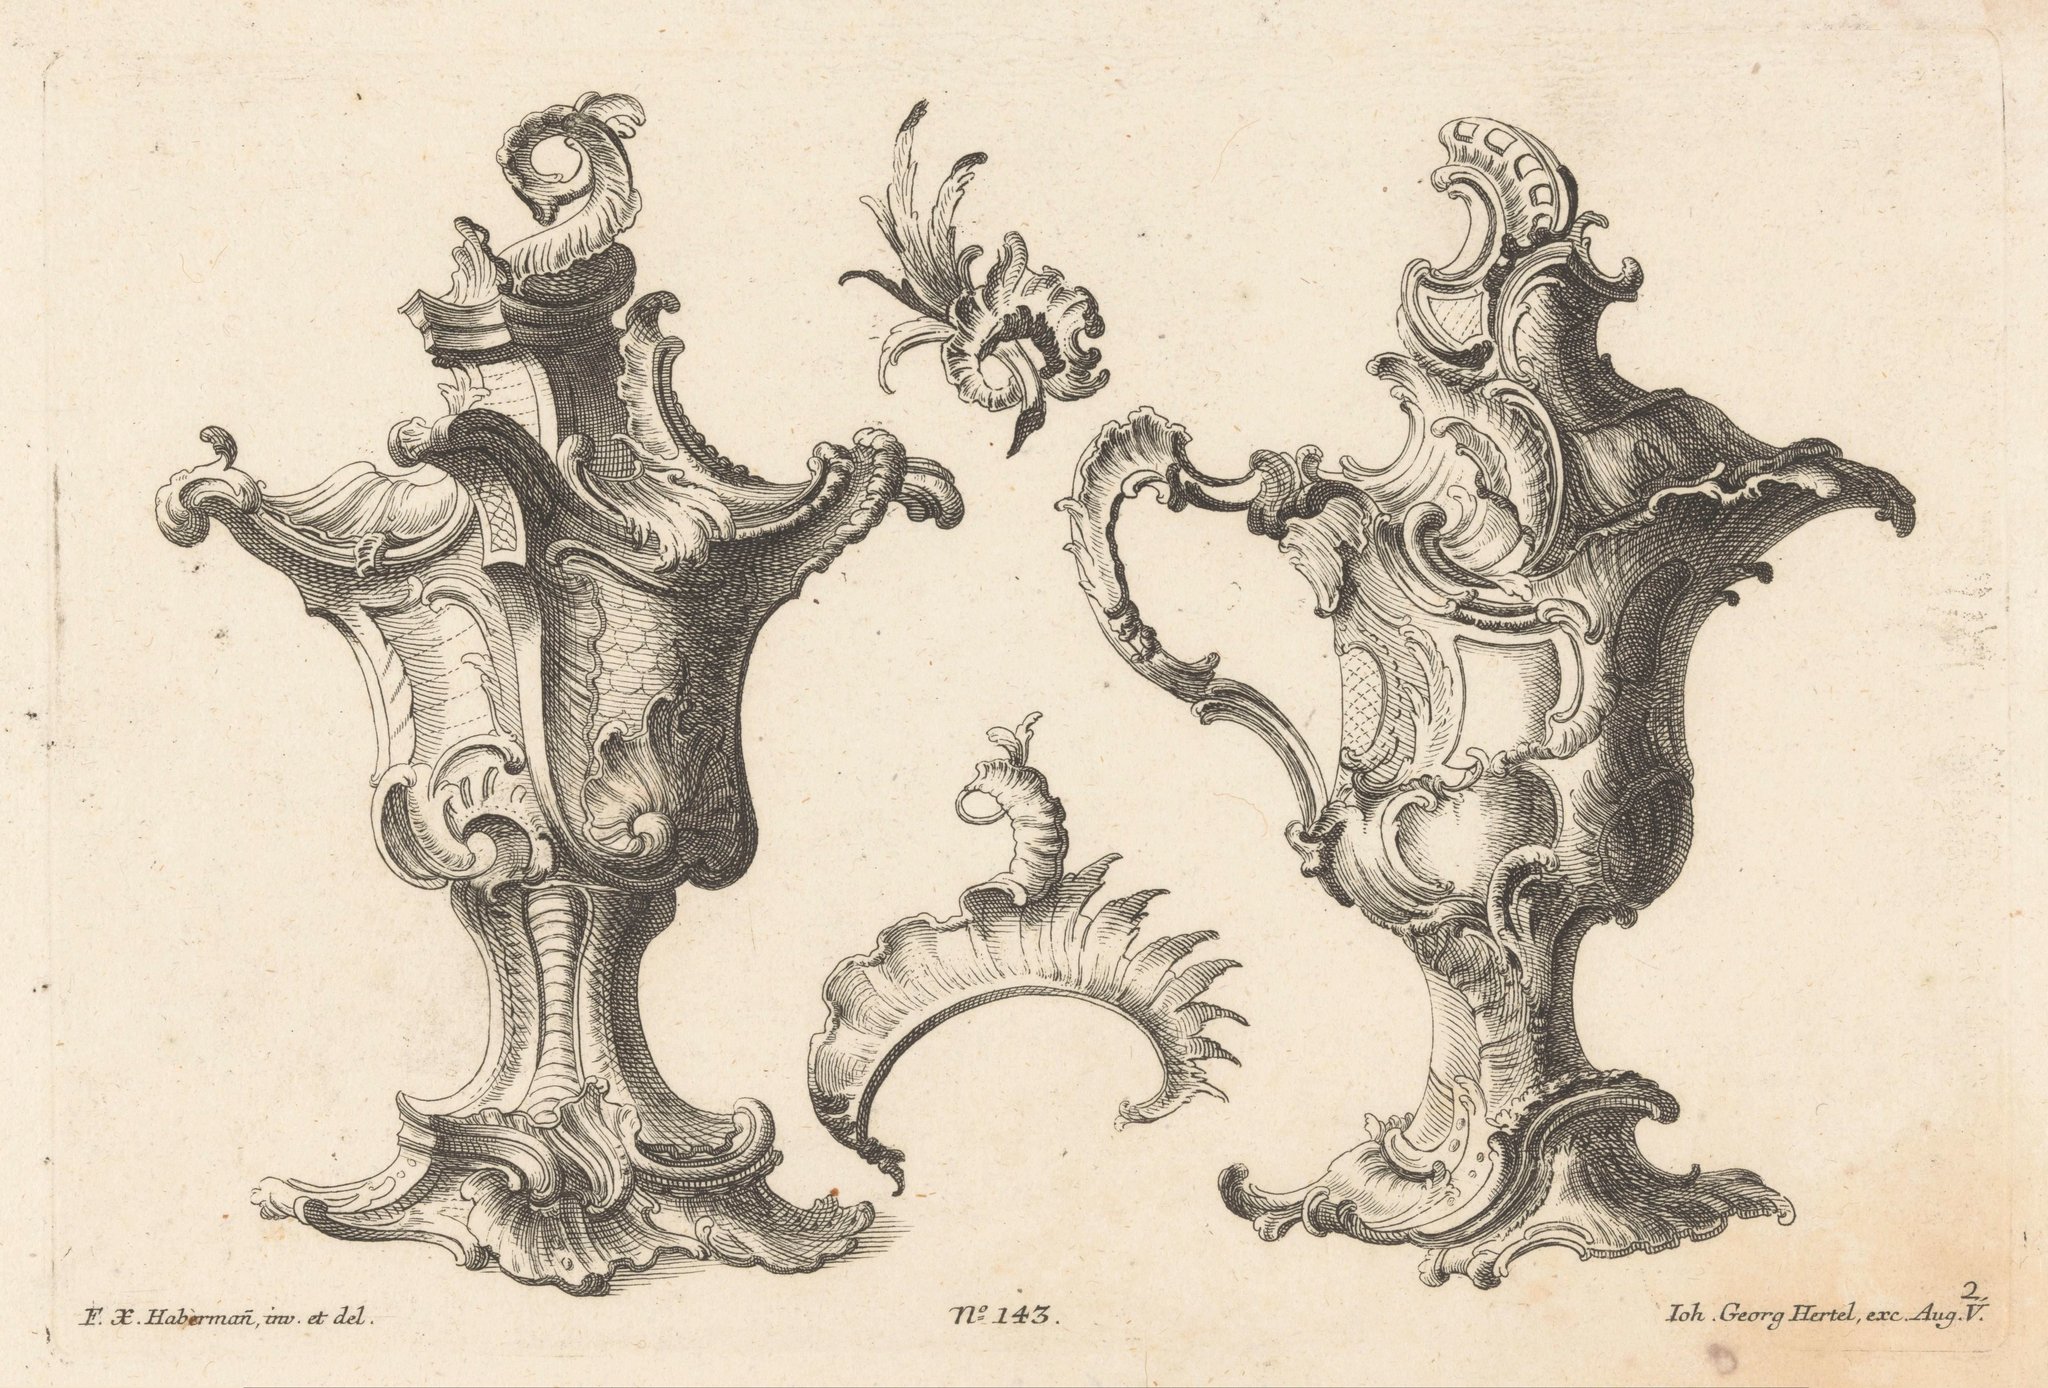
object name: print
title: Kan en vaas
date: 1731-1775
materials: paper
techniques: etching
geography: augsburg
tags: rocaille ornament, vase ~ ornament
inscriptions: watermark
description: Een kan en een vaas met rocaille ornamenten. Uitgeversnummer 143.